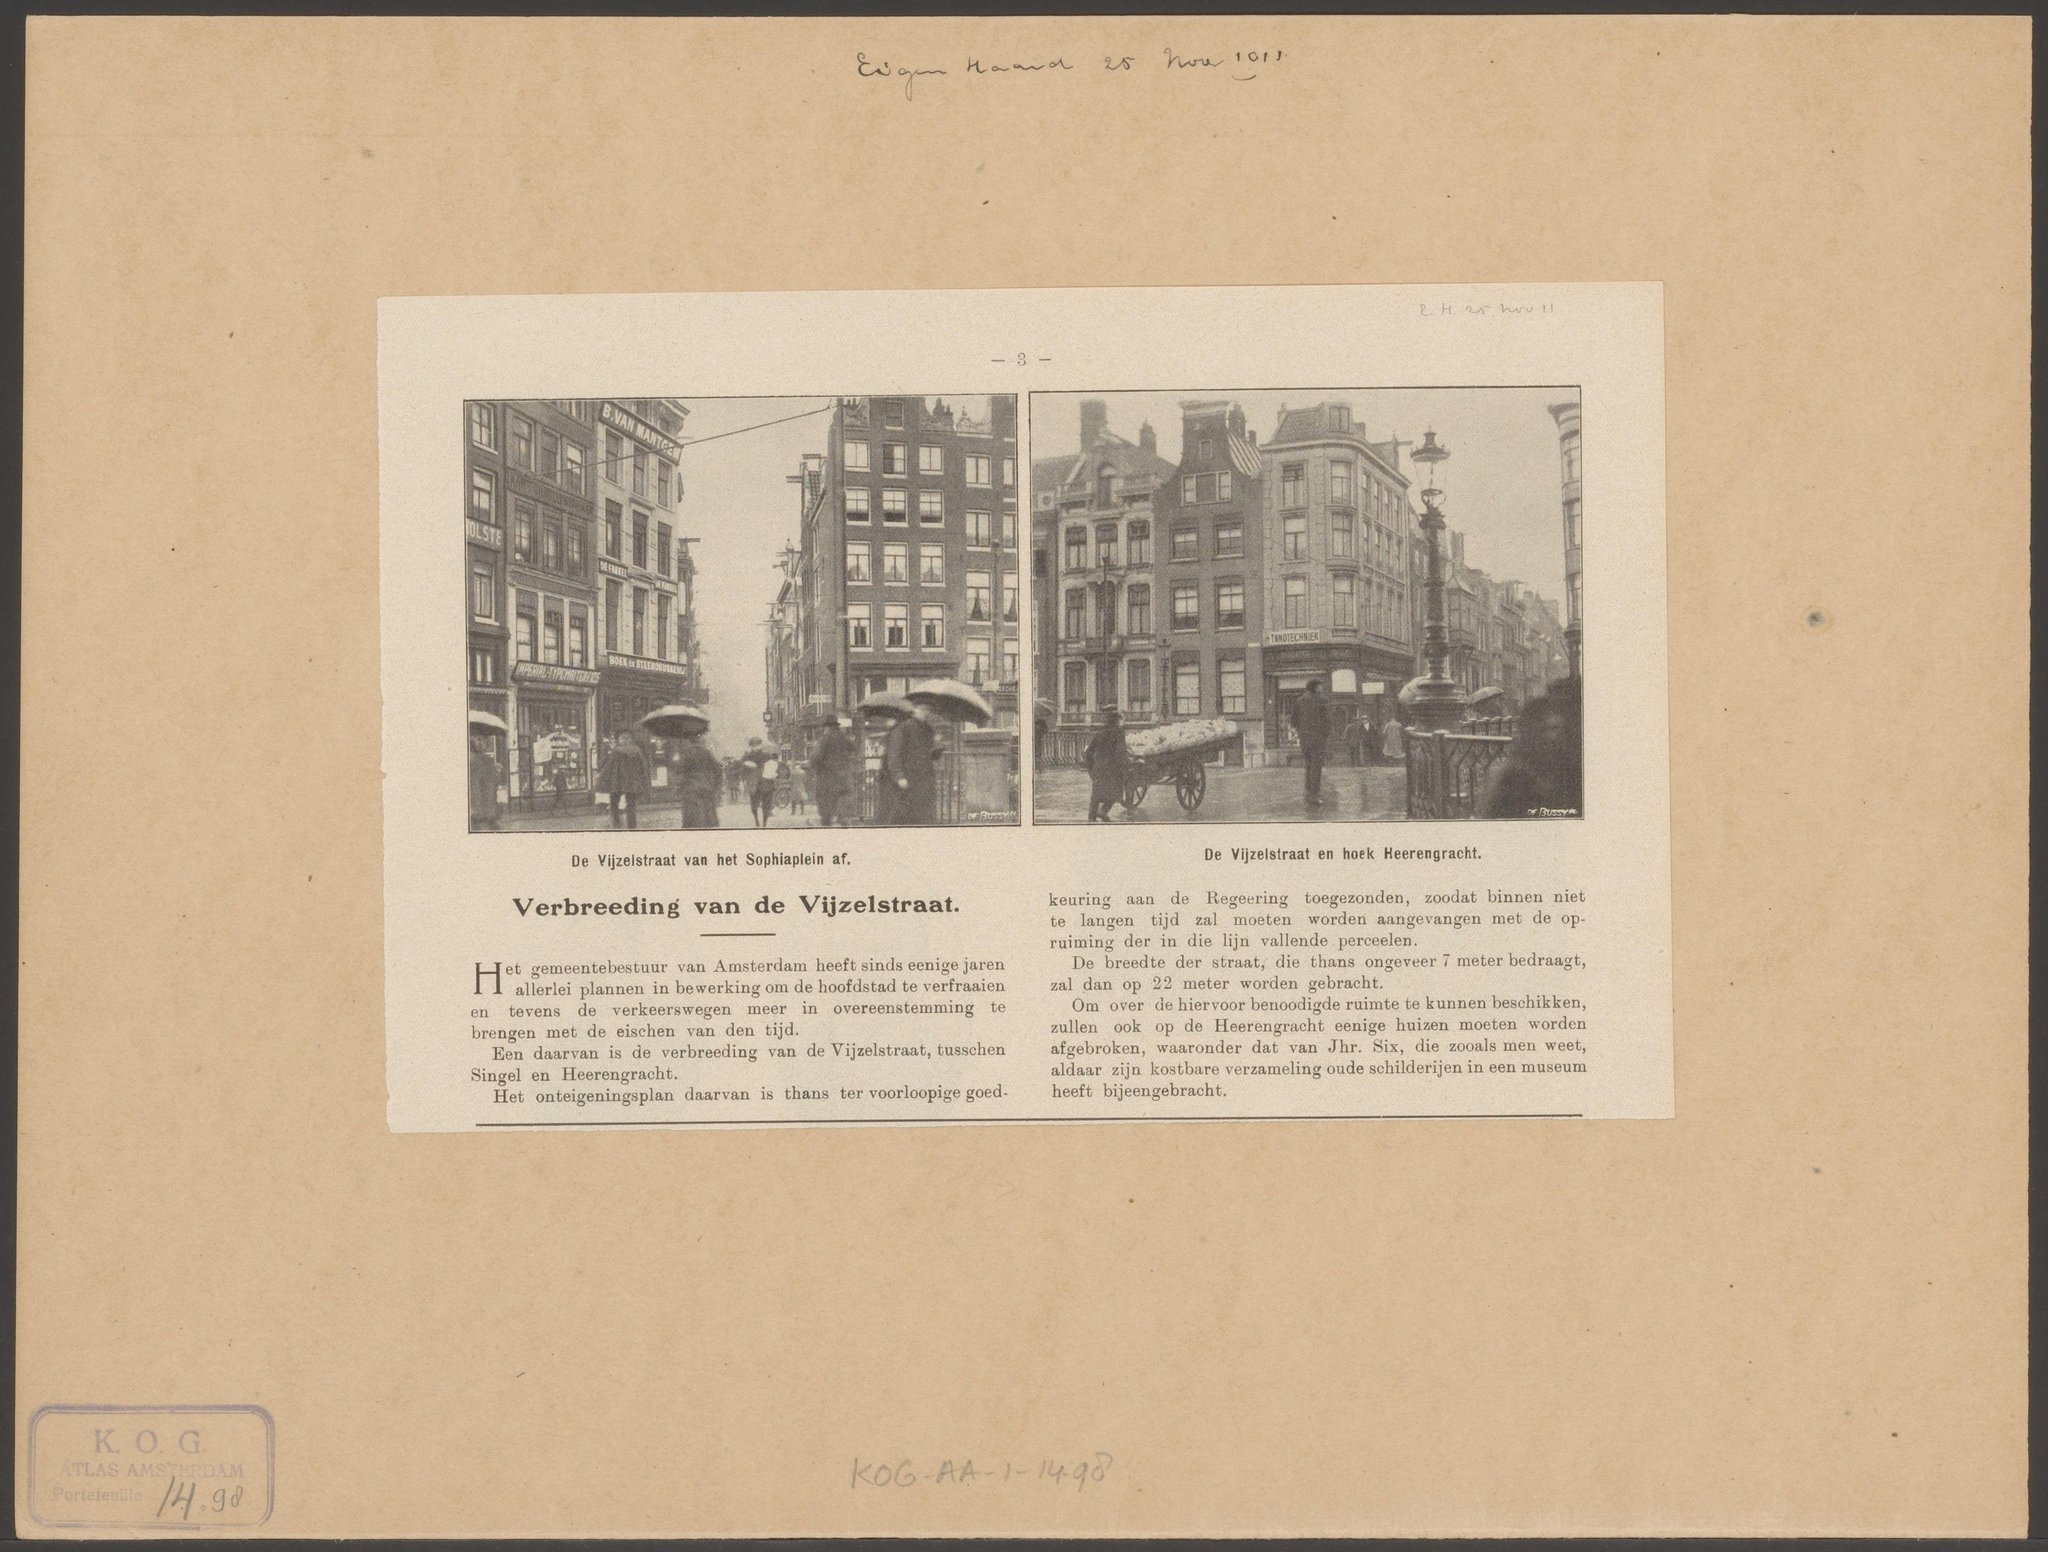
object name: photomechanical print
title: Gezicht op de Vijzelstraat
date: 1911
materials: paper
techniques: letterpress printing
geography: haarlem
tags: city-view in general; 'veduta', façade (of house or building), street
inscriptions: collector's mark: ‘14.98’ Lugt 1641b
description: Onderwerpsrubriek binnen de Atlas Amsterdam: Voorburgwal (O.Z.), Voorweg, Vijgendam, Vijzelstraat.